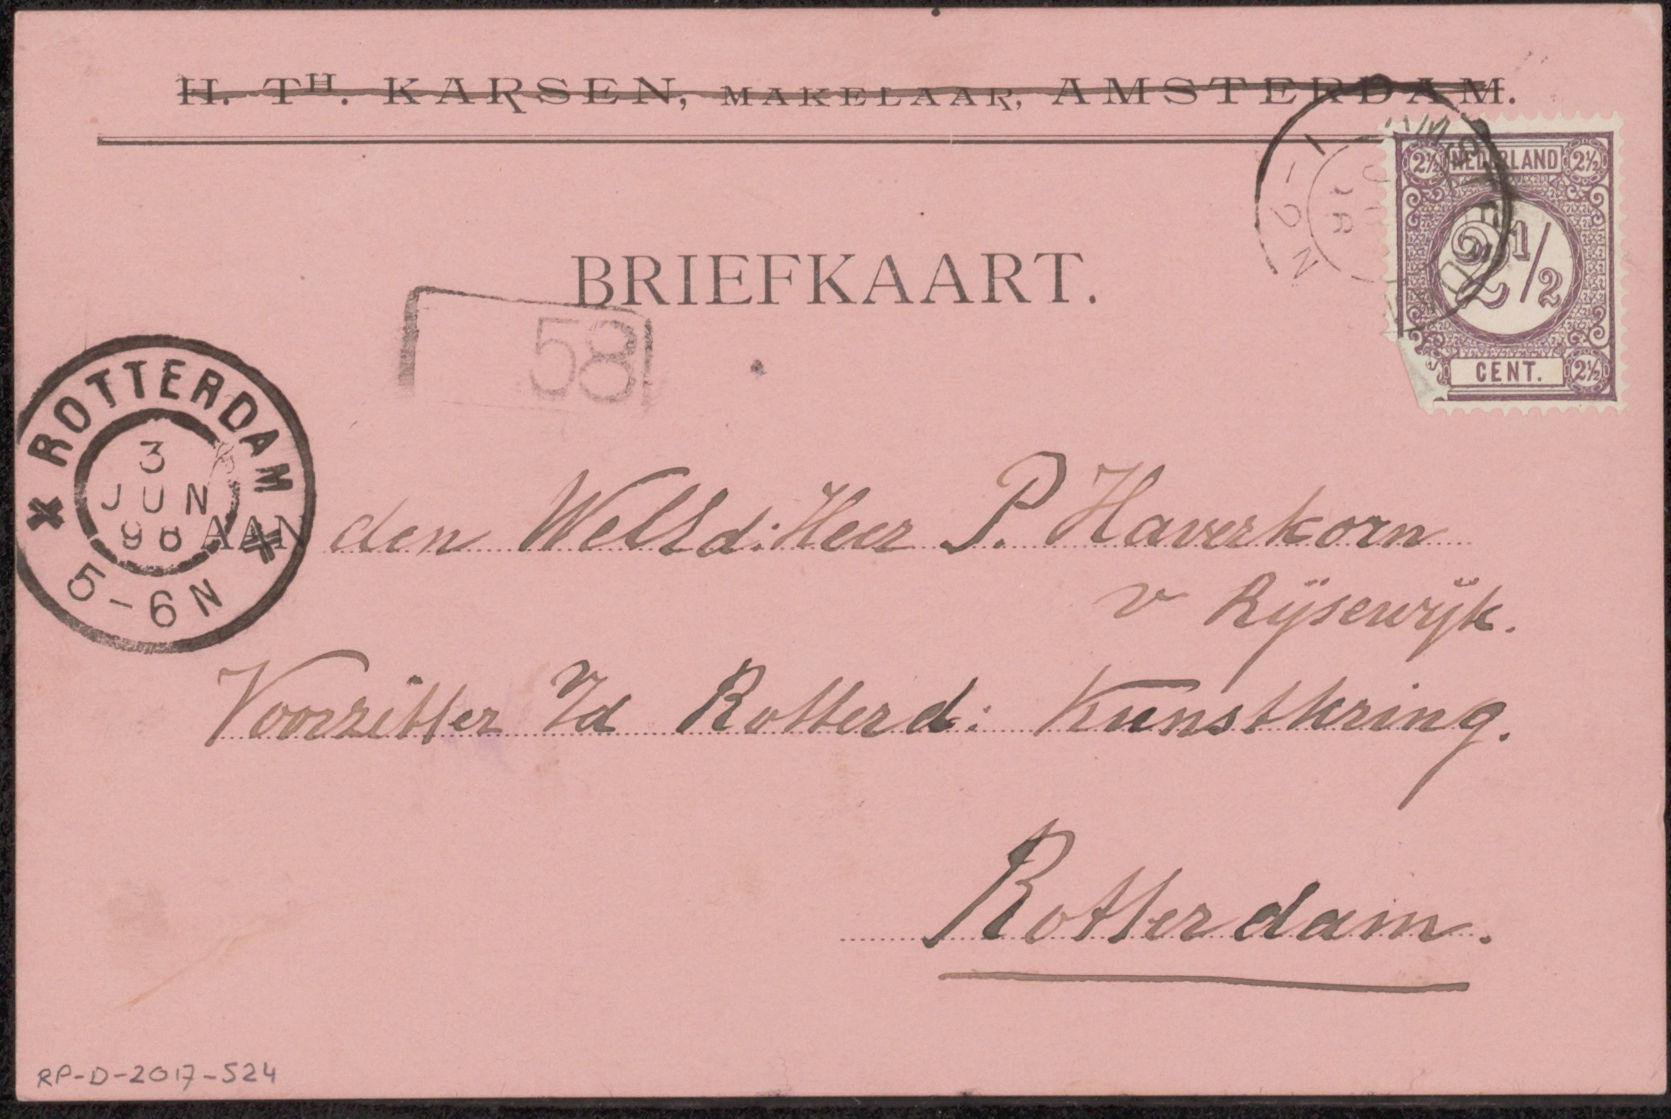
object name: postcard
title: Briefkaart aan Pieter Haverkorn van Rijsewijk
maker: eduard karsen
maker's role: draughtsman, painter, print maker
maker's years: 1860-1941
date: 1896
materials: cardboard, ink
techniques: pen, writing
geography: amsterdam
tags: pieter haverkorn van rijsewijk, drawing